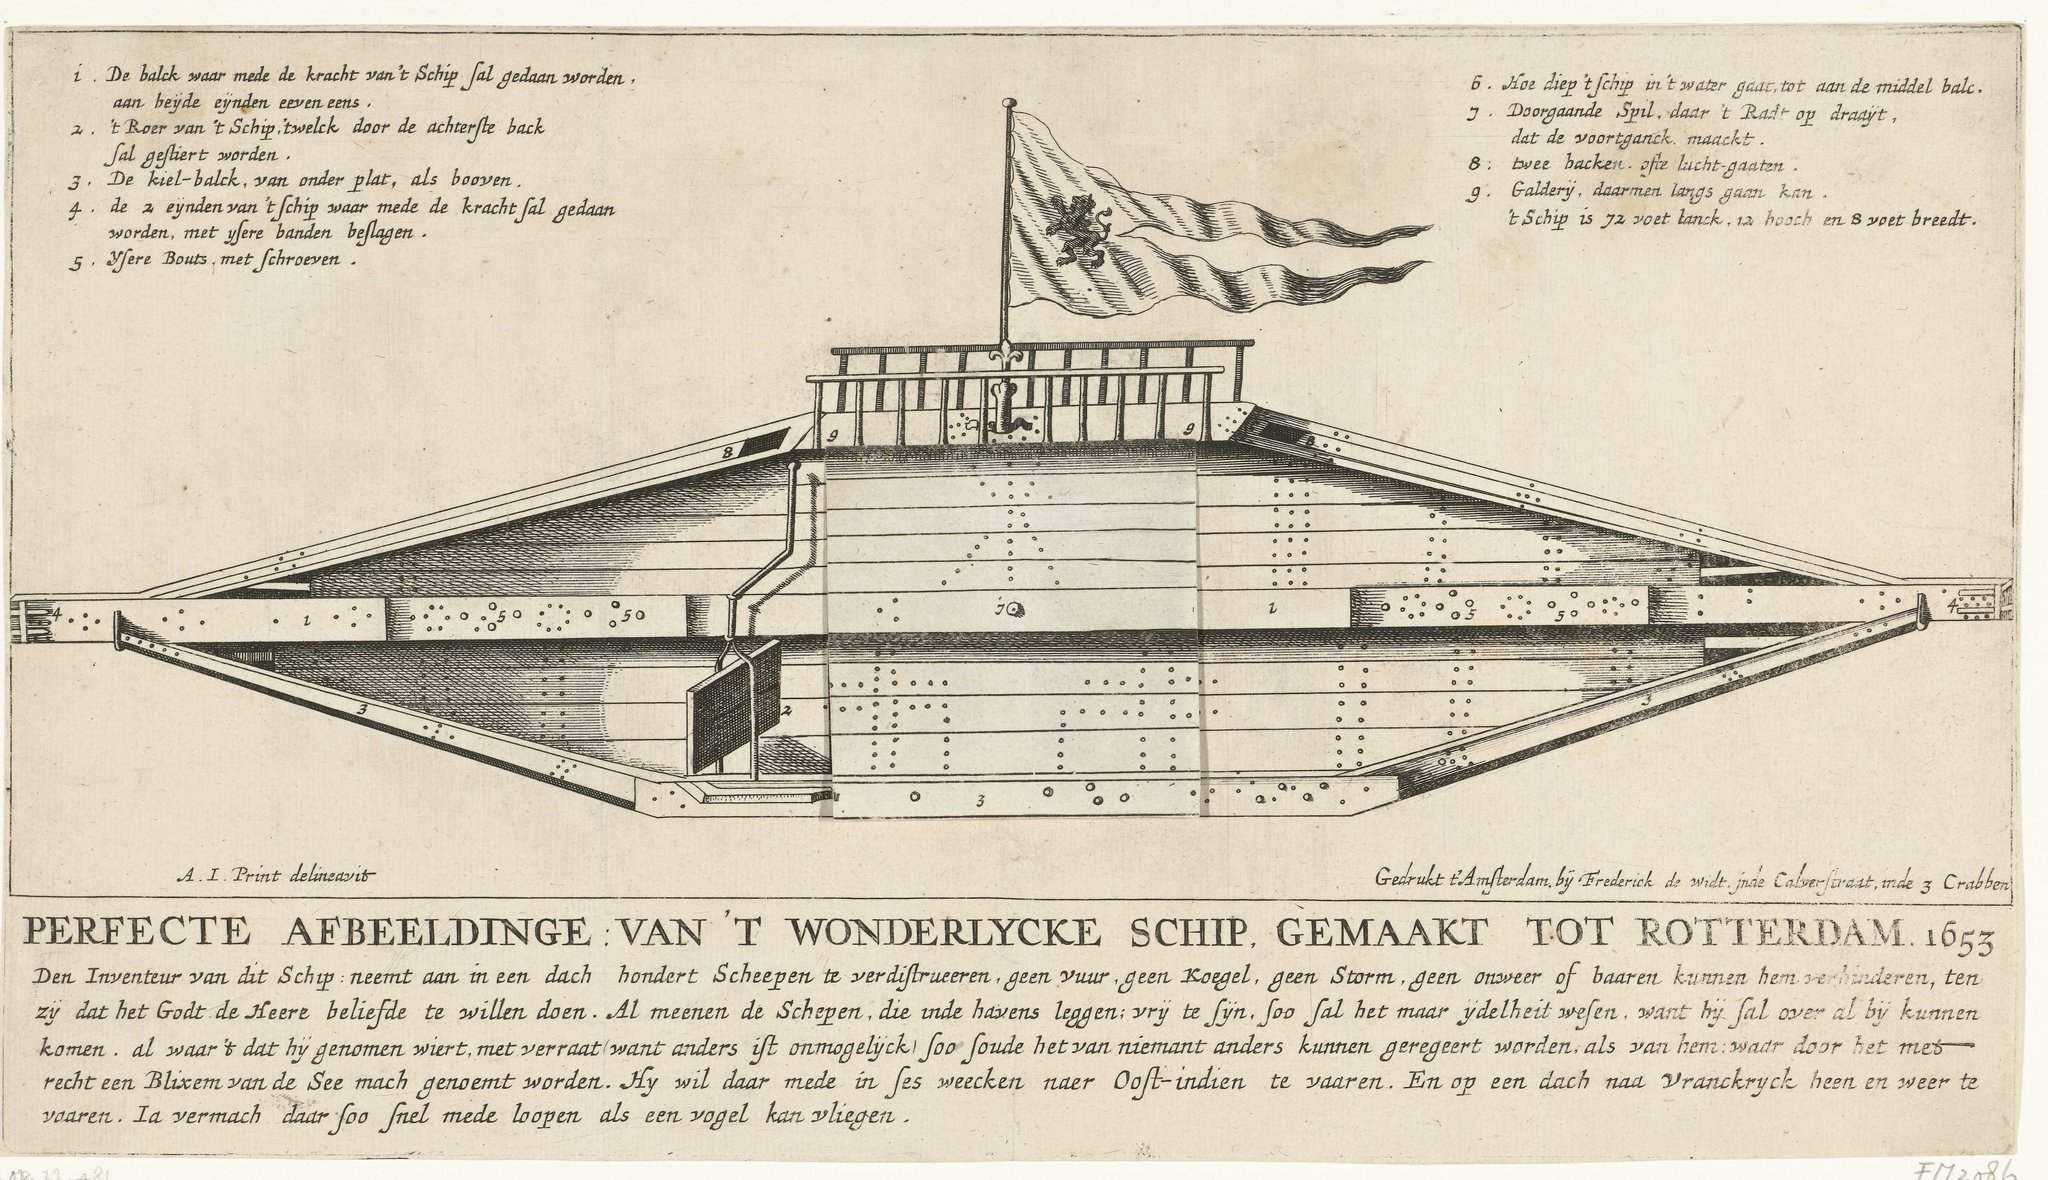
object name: print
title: Het malle schip van Rotterdam, 1653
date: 1653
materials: paper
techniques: etching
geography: northern netherlands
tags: improvised and unusual traffic on the water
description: Het malle of wonderlijke schip van Rotterdam, ontworpen door Jean Duson, 1653. Dichtgetimmerd ruitvormig houten schip met in het midden een scheprad of schroef (bedekt door een daarover vastgehecht blaadje). Met onderschrift van 6 regels, in de voorstelling de legenda 1-9.